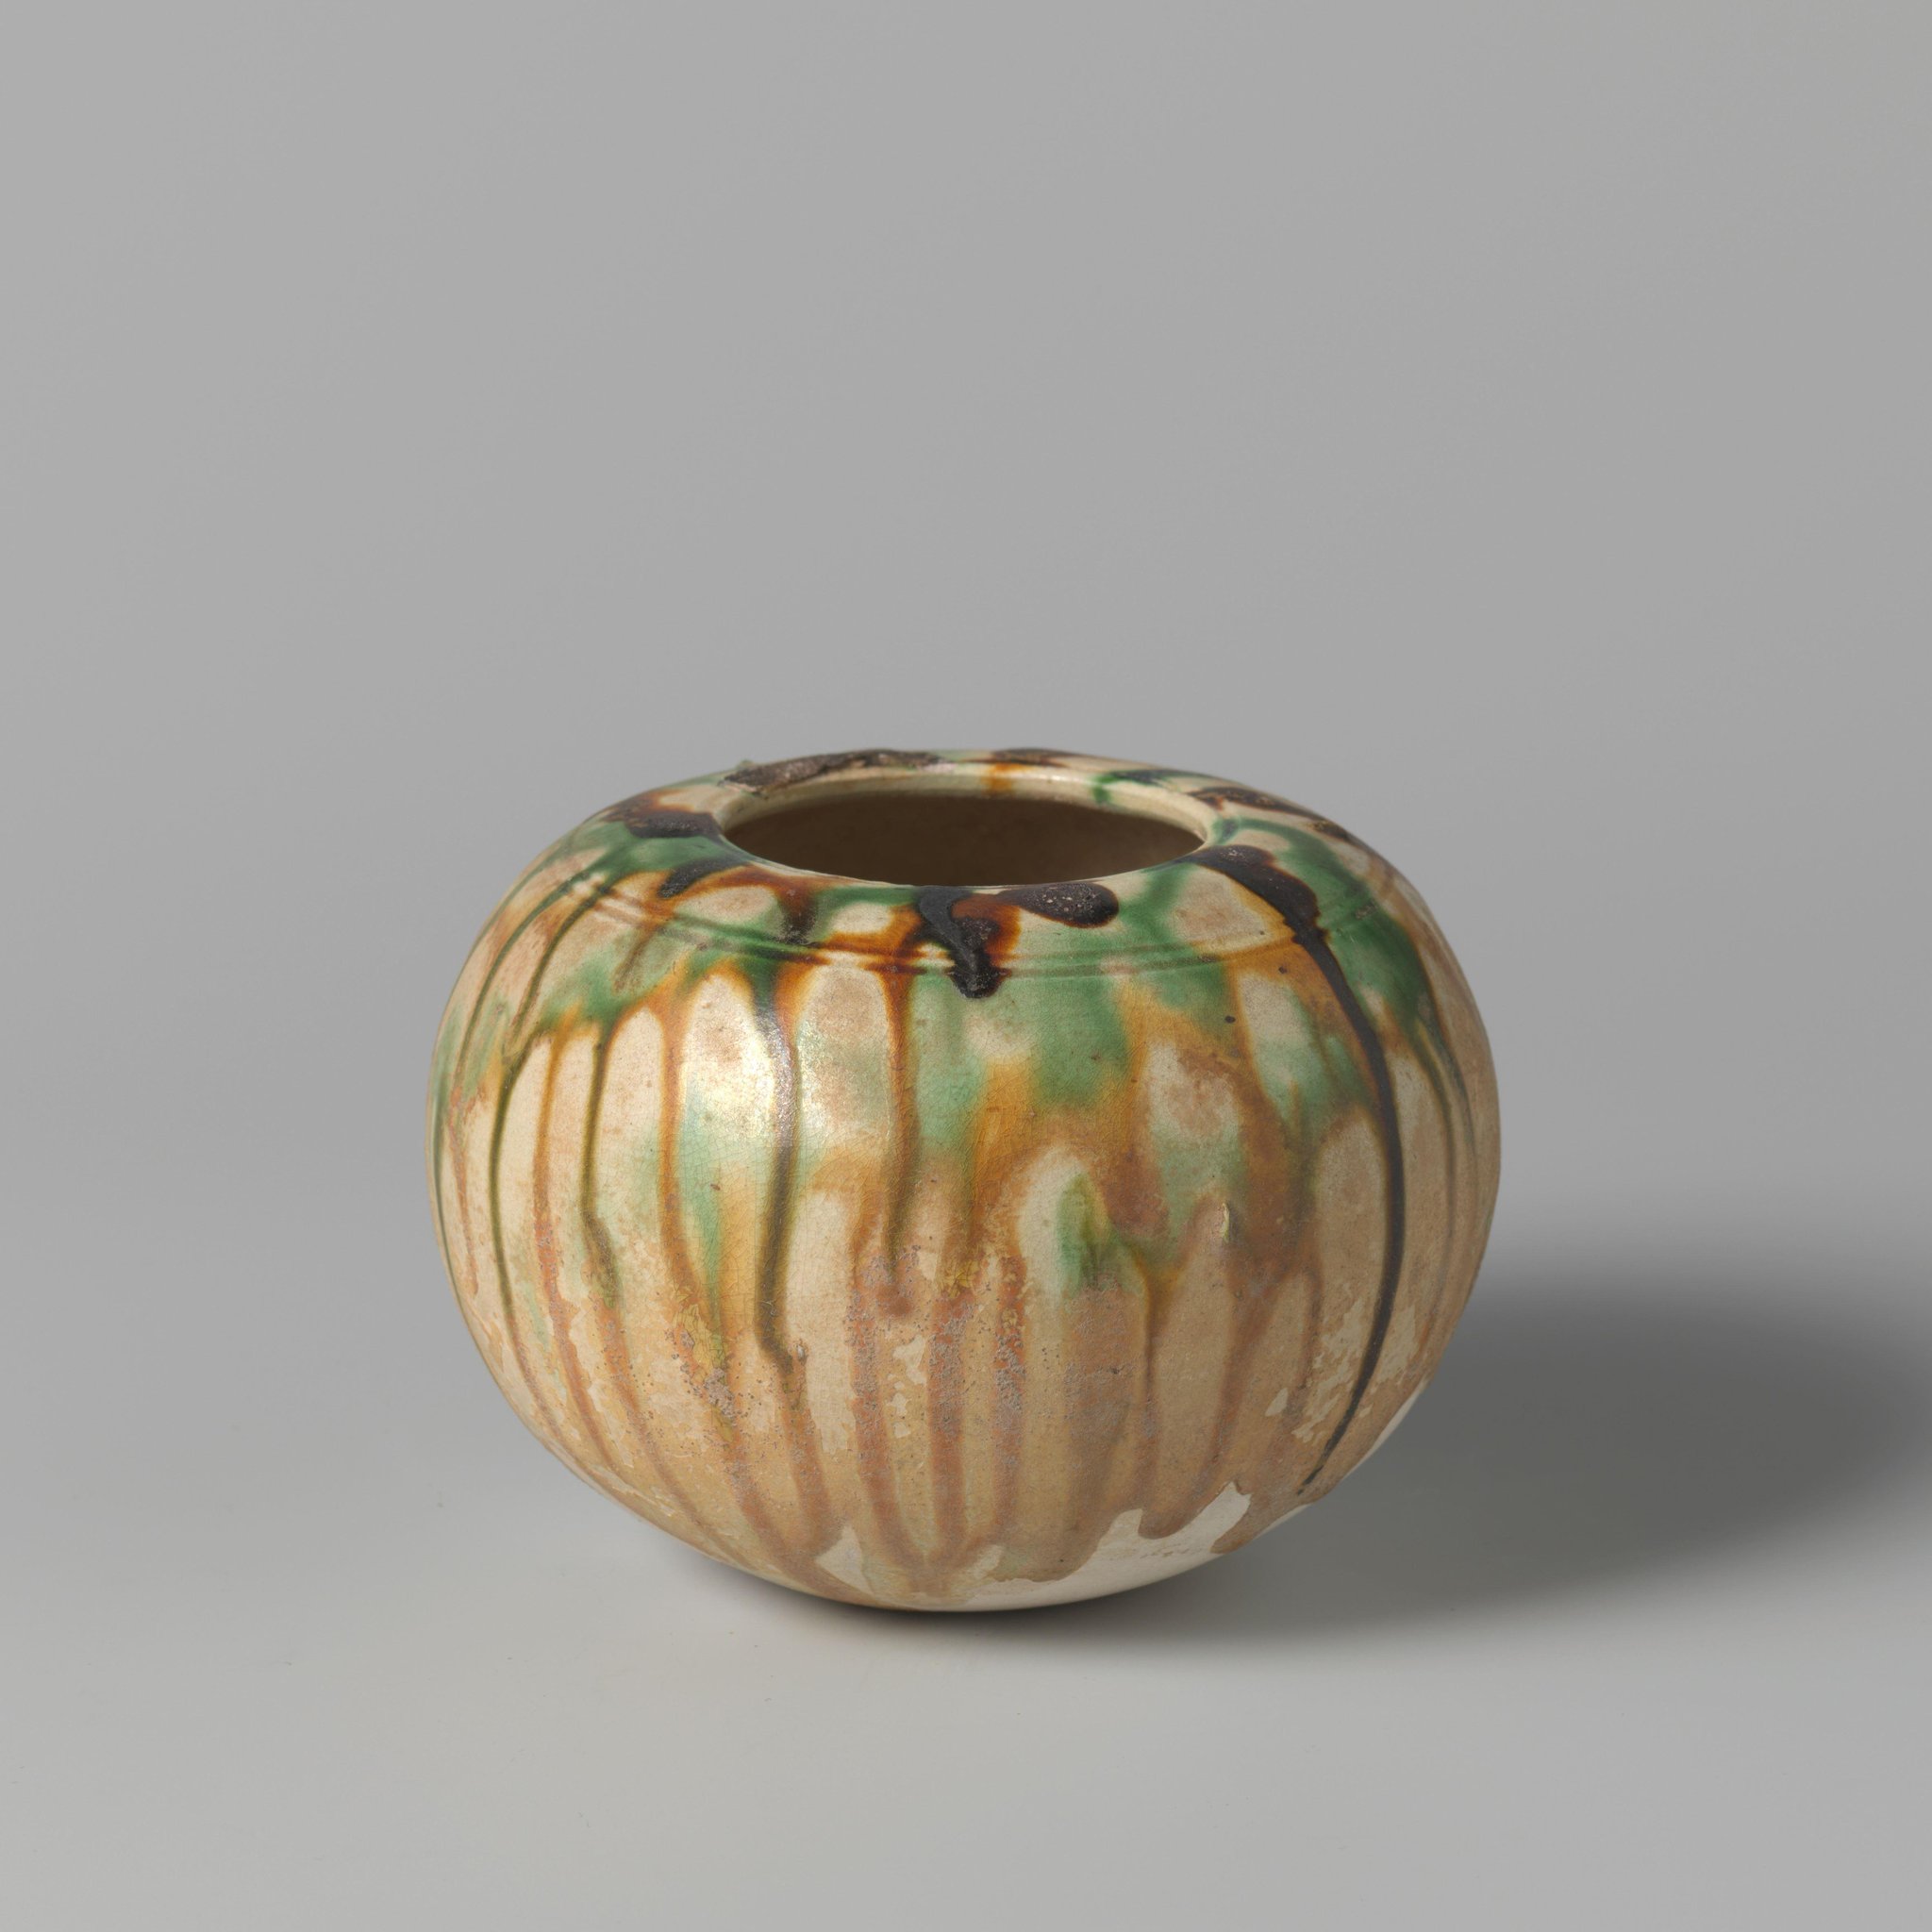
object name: lid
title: Covered jar with a three-colored glaze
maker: Anonymous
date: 618-906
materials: earthenware, glaze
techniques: firing, turning, vitrification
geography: china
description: Dekselpot van aardewerk met een bolvormig lichaam, bedekt met een groen, bruin en crèmekleurig glazuur. De deksel met bruine en groene vlekken. Sancai, Tang.